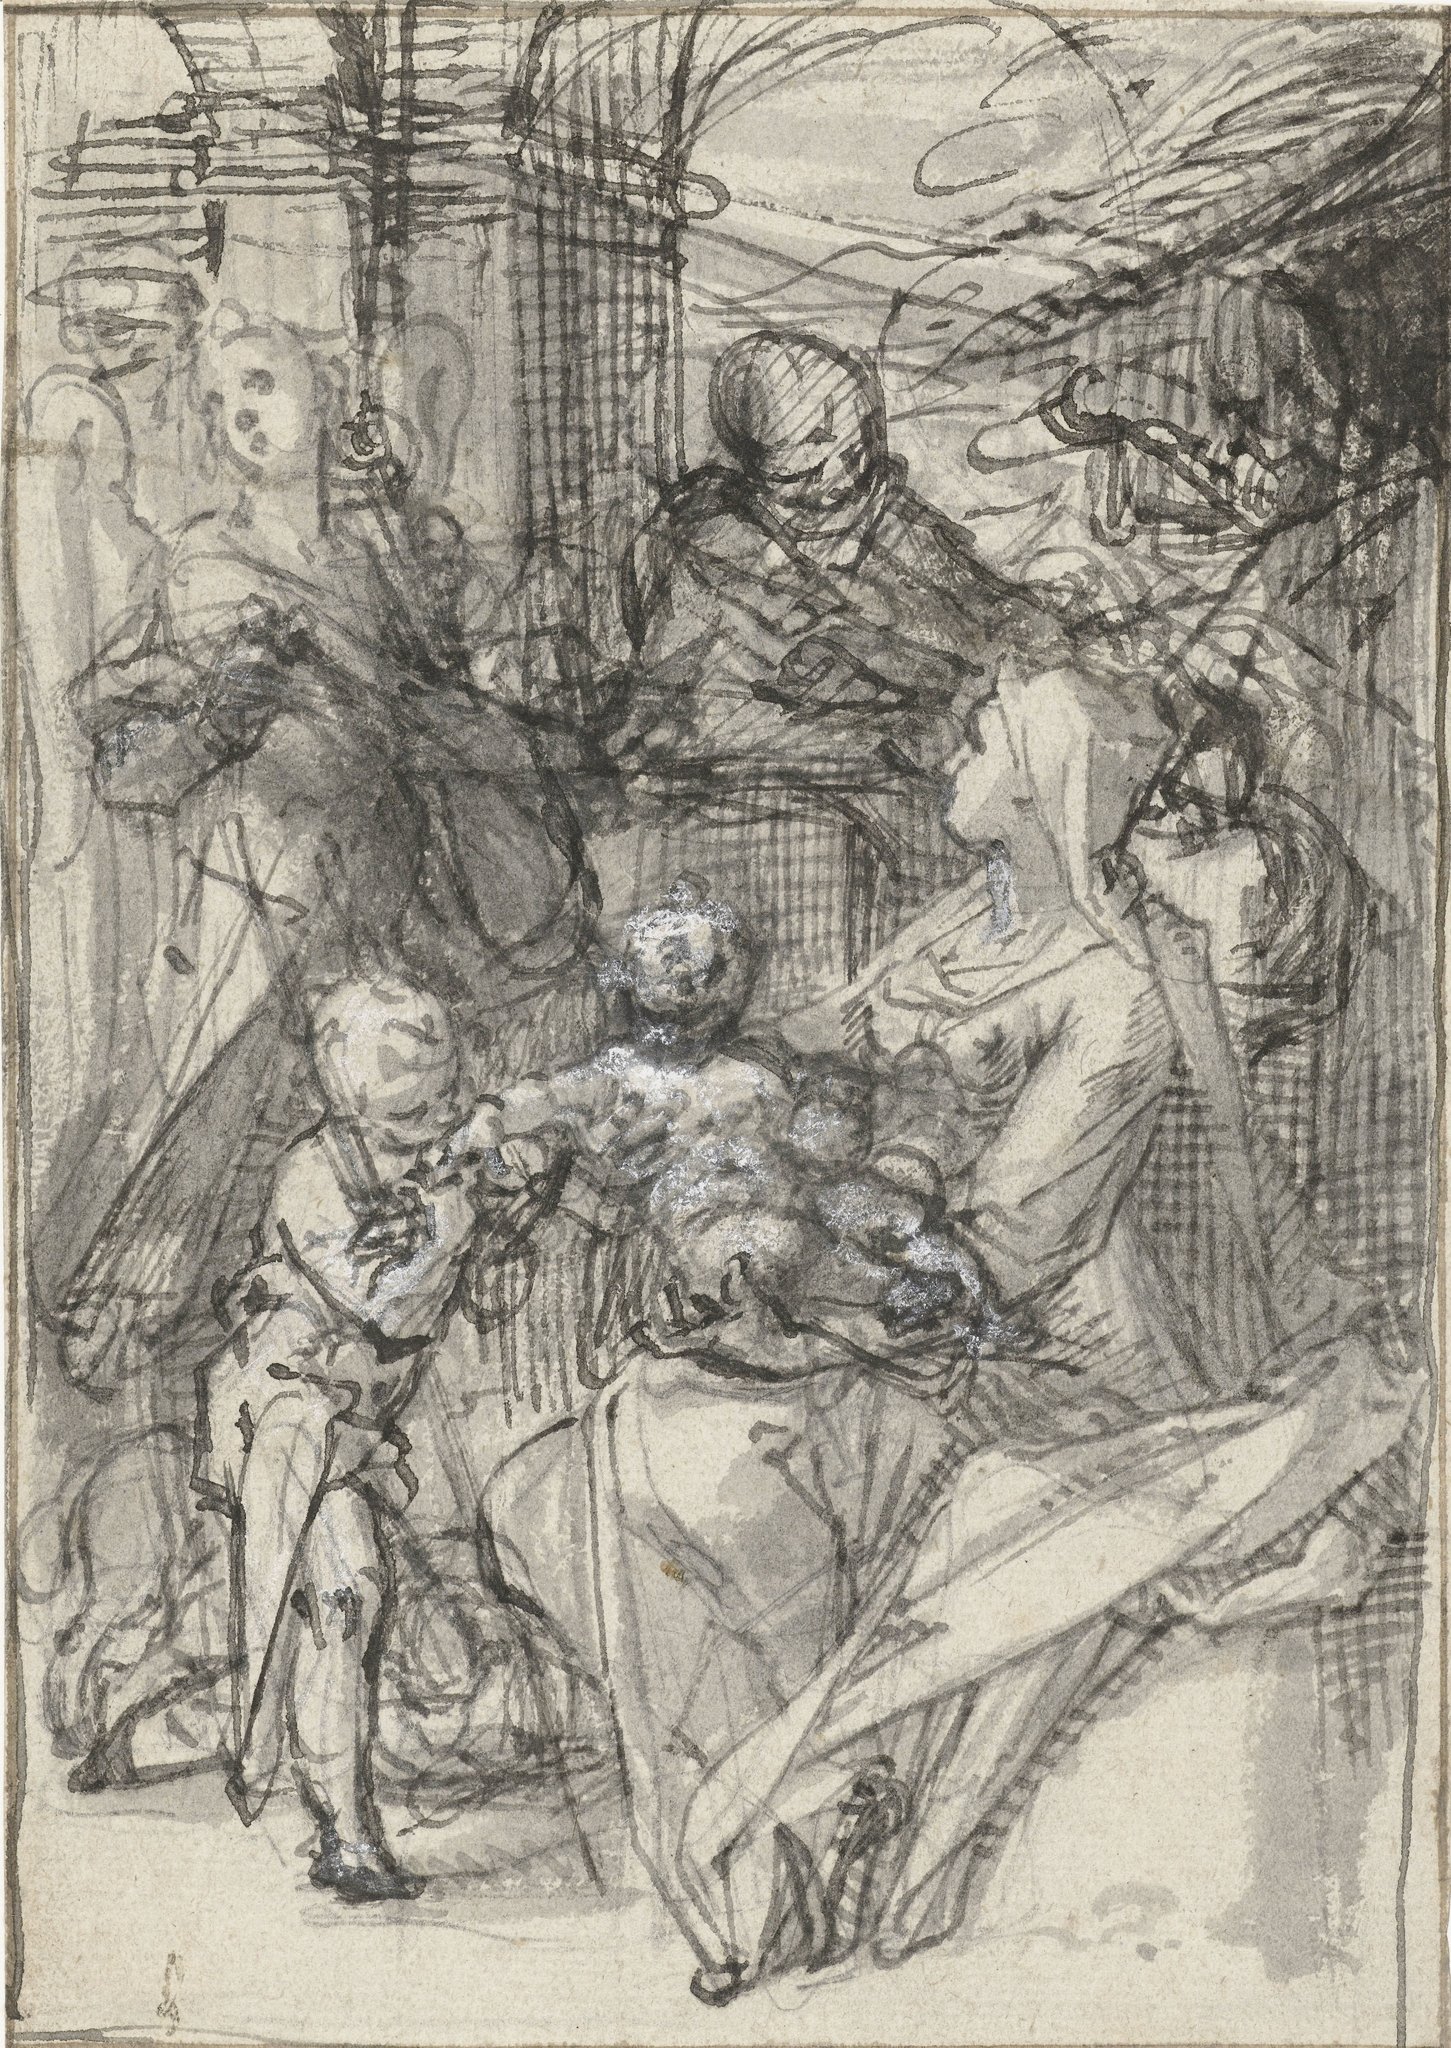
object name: drawing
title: Maria met kind, Johannes de Doper en een engel die viool speelt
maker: bartholomeus spranger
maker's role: draughtsman, painter, print maker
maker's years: 1546-1611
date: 1556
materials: ink, paint, paper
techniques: brush, pen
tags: holy family with john the baptist (as child) (+ angel(s))